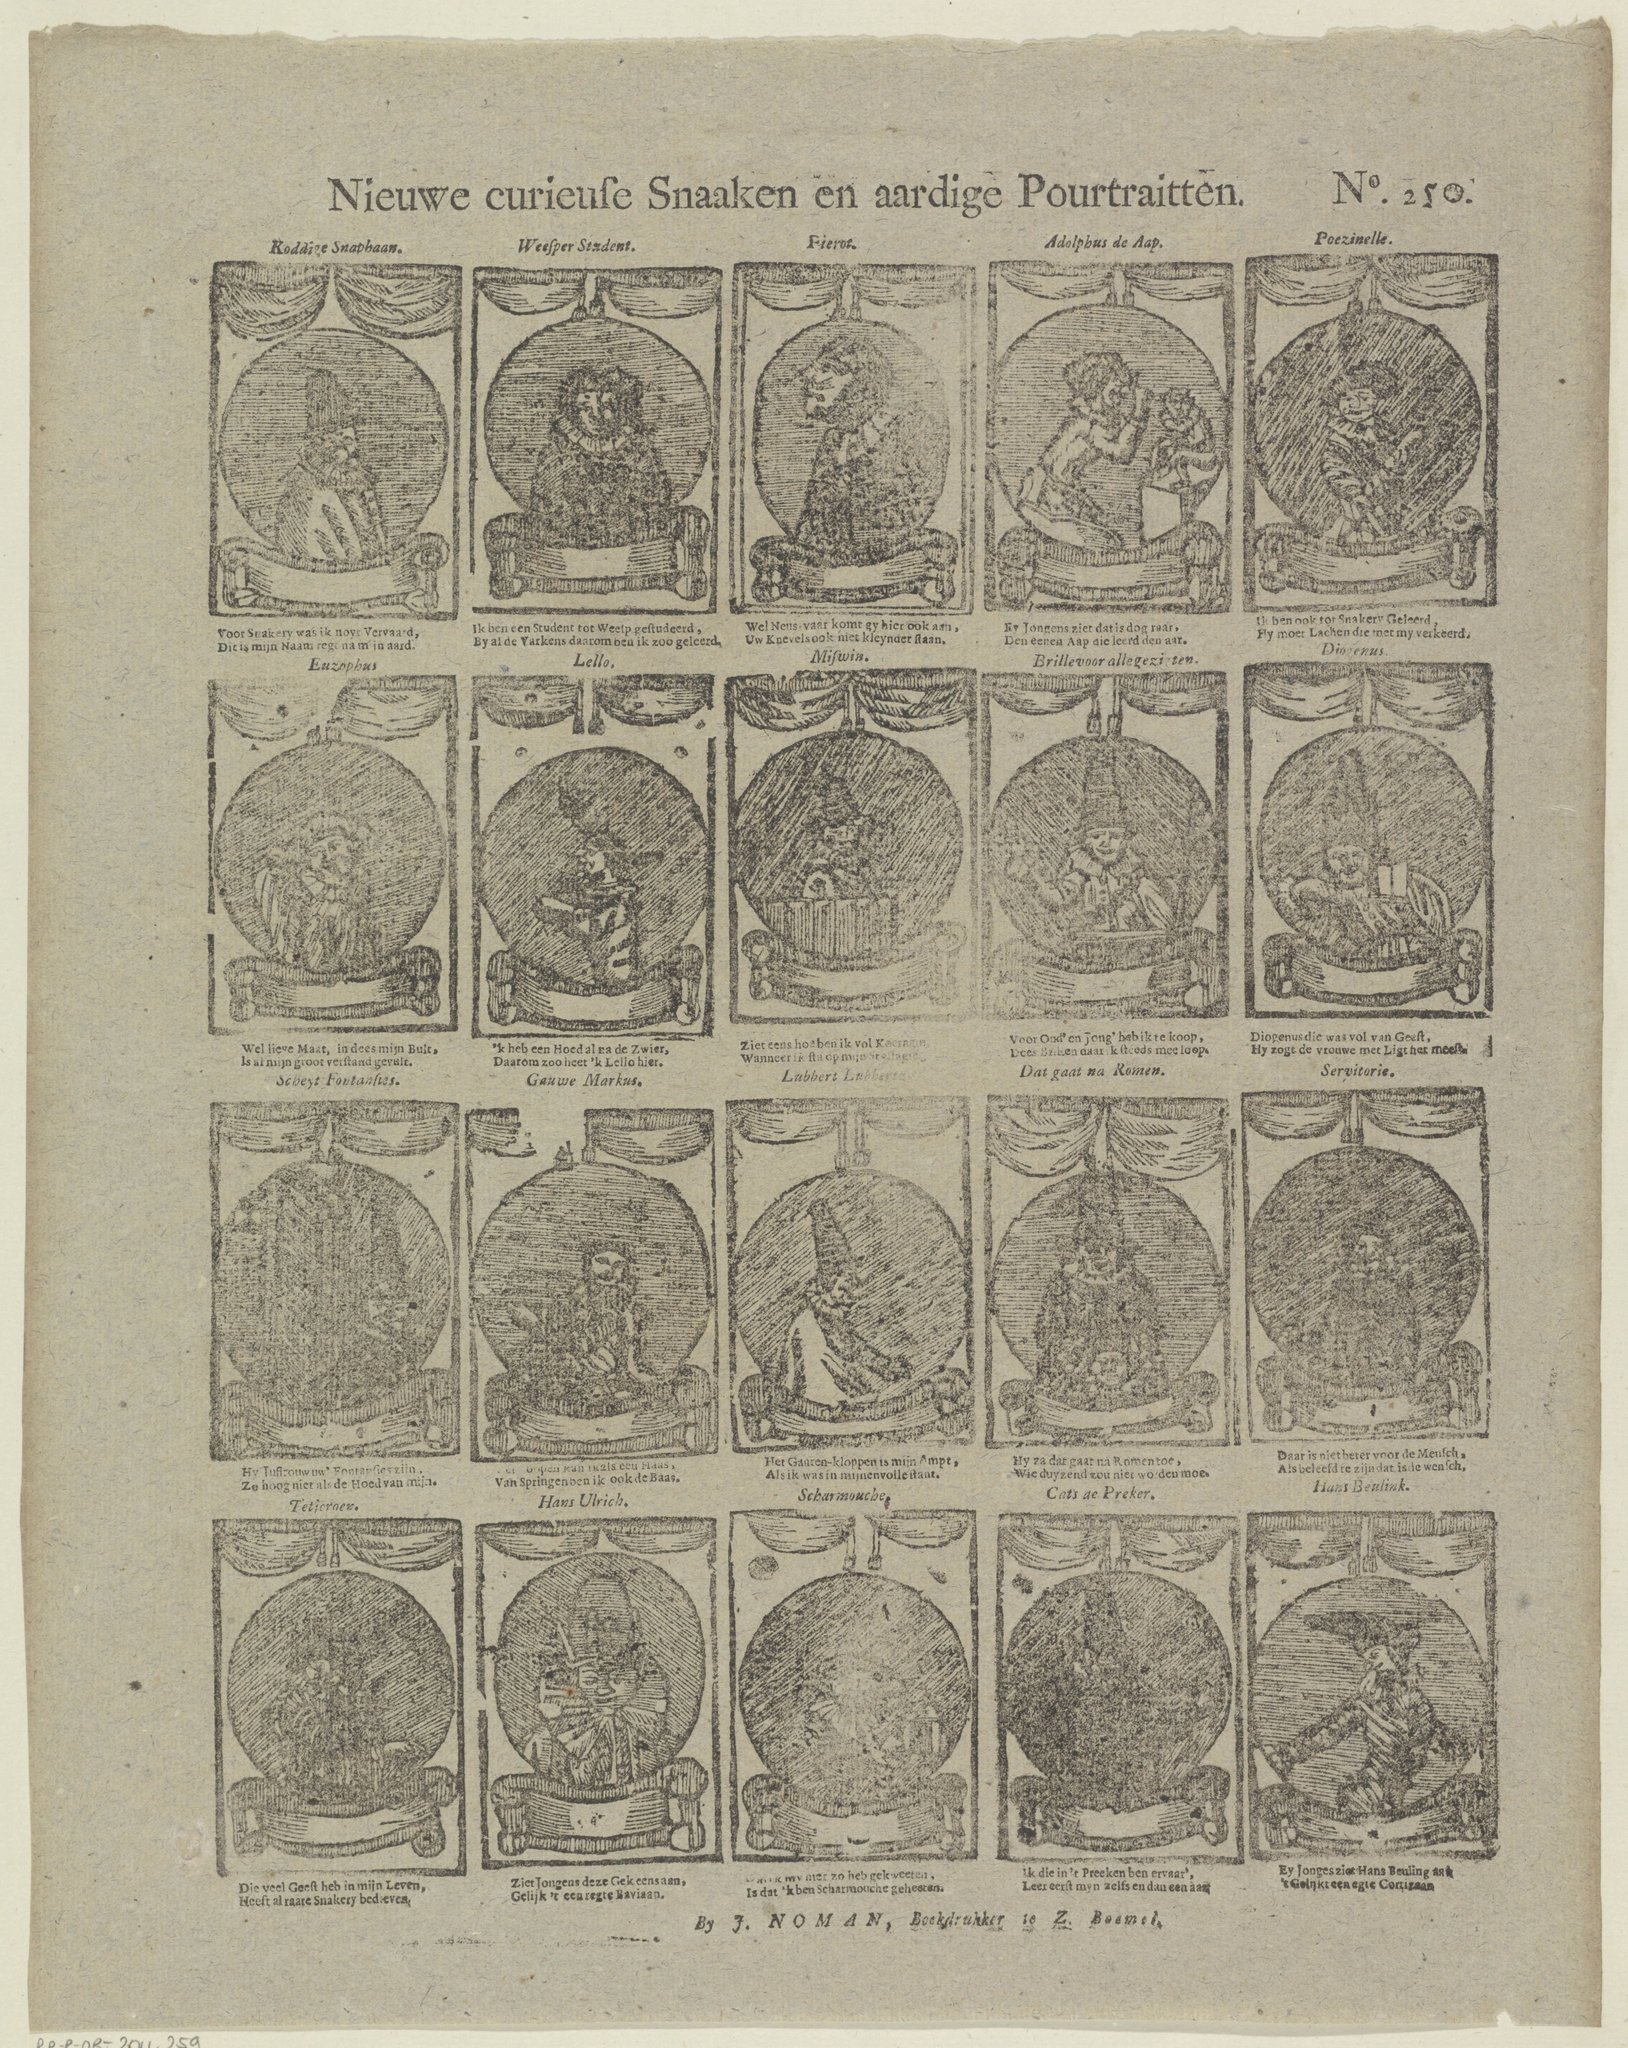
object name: popular print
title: Nieuwe curieuse snaaken en aardige pourtraitten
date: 1806-1830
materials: paper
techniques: letterpress printing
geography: zaltbommel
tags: types in 'commedia dell'arte', human types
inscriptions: collector's mark: Lugt 2760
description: Blad met 20 medaillons met portretten van populaire figuren, onder wie Tetjeroen, Aesopus en Hans Ulrich. Onder elke afbeelding een tweeregelig vers, boven elke afbeelding de naam van de geportretteerde. Genummerd rechtsboven: No. 250.